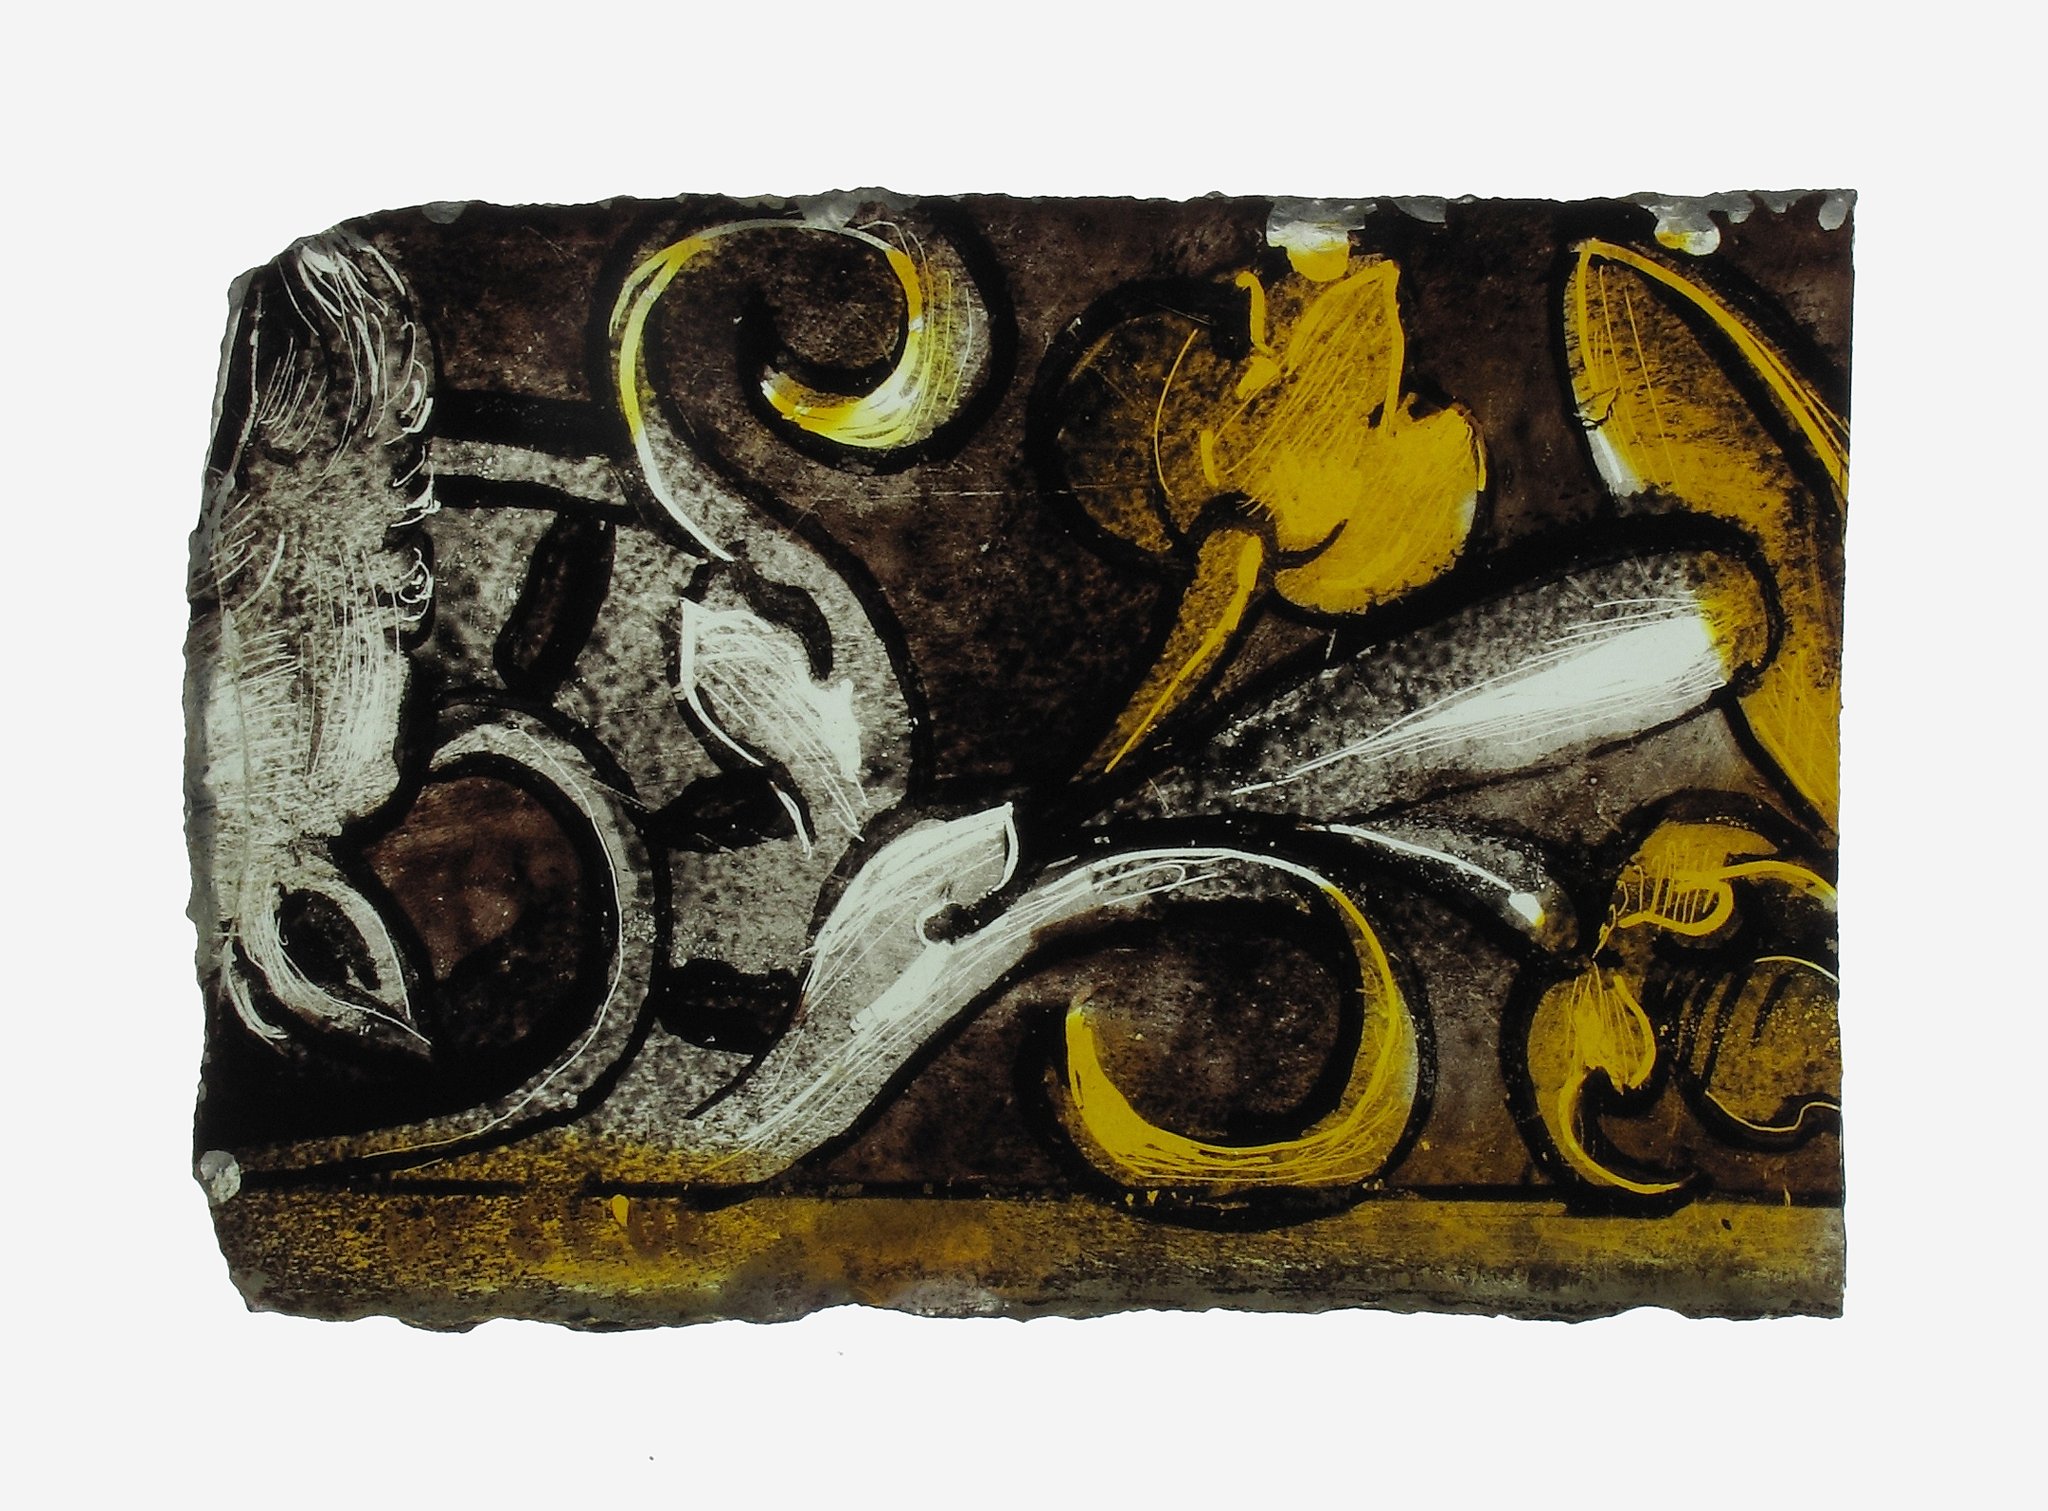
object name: fragment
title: Glass Fragment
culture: european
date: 1501-1600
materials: glass